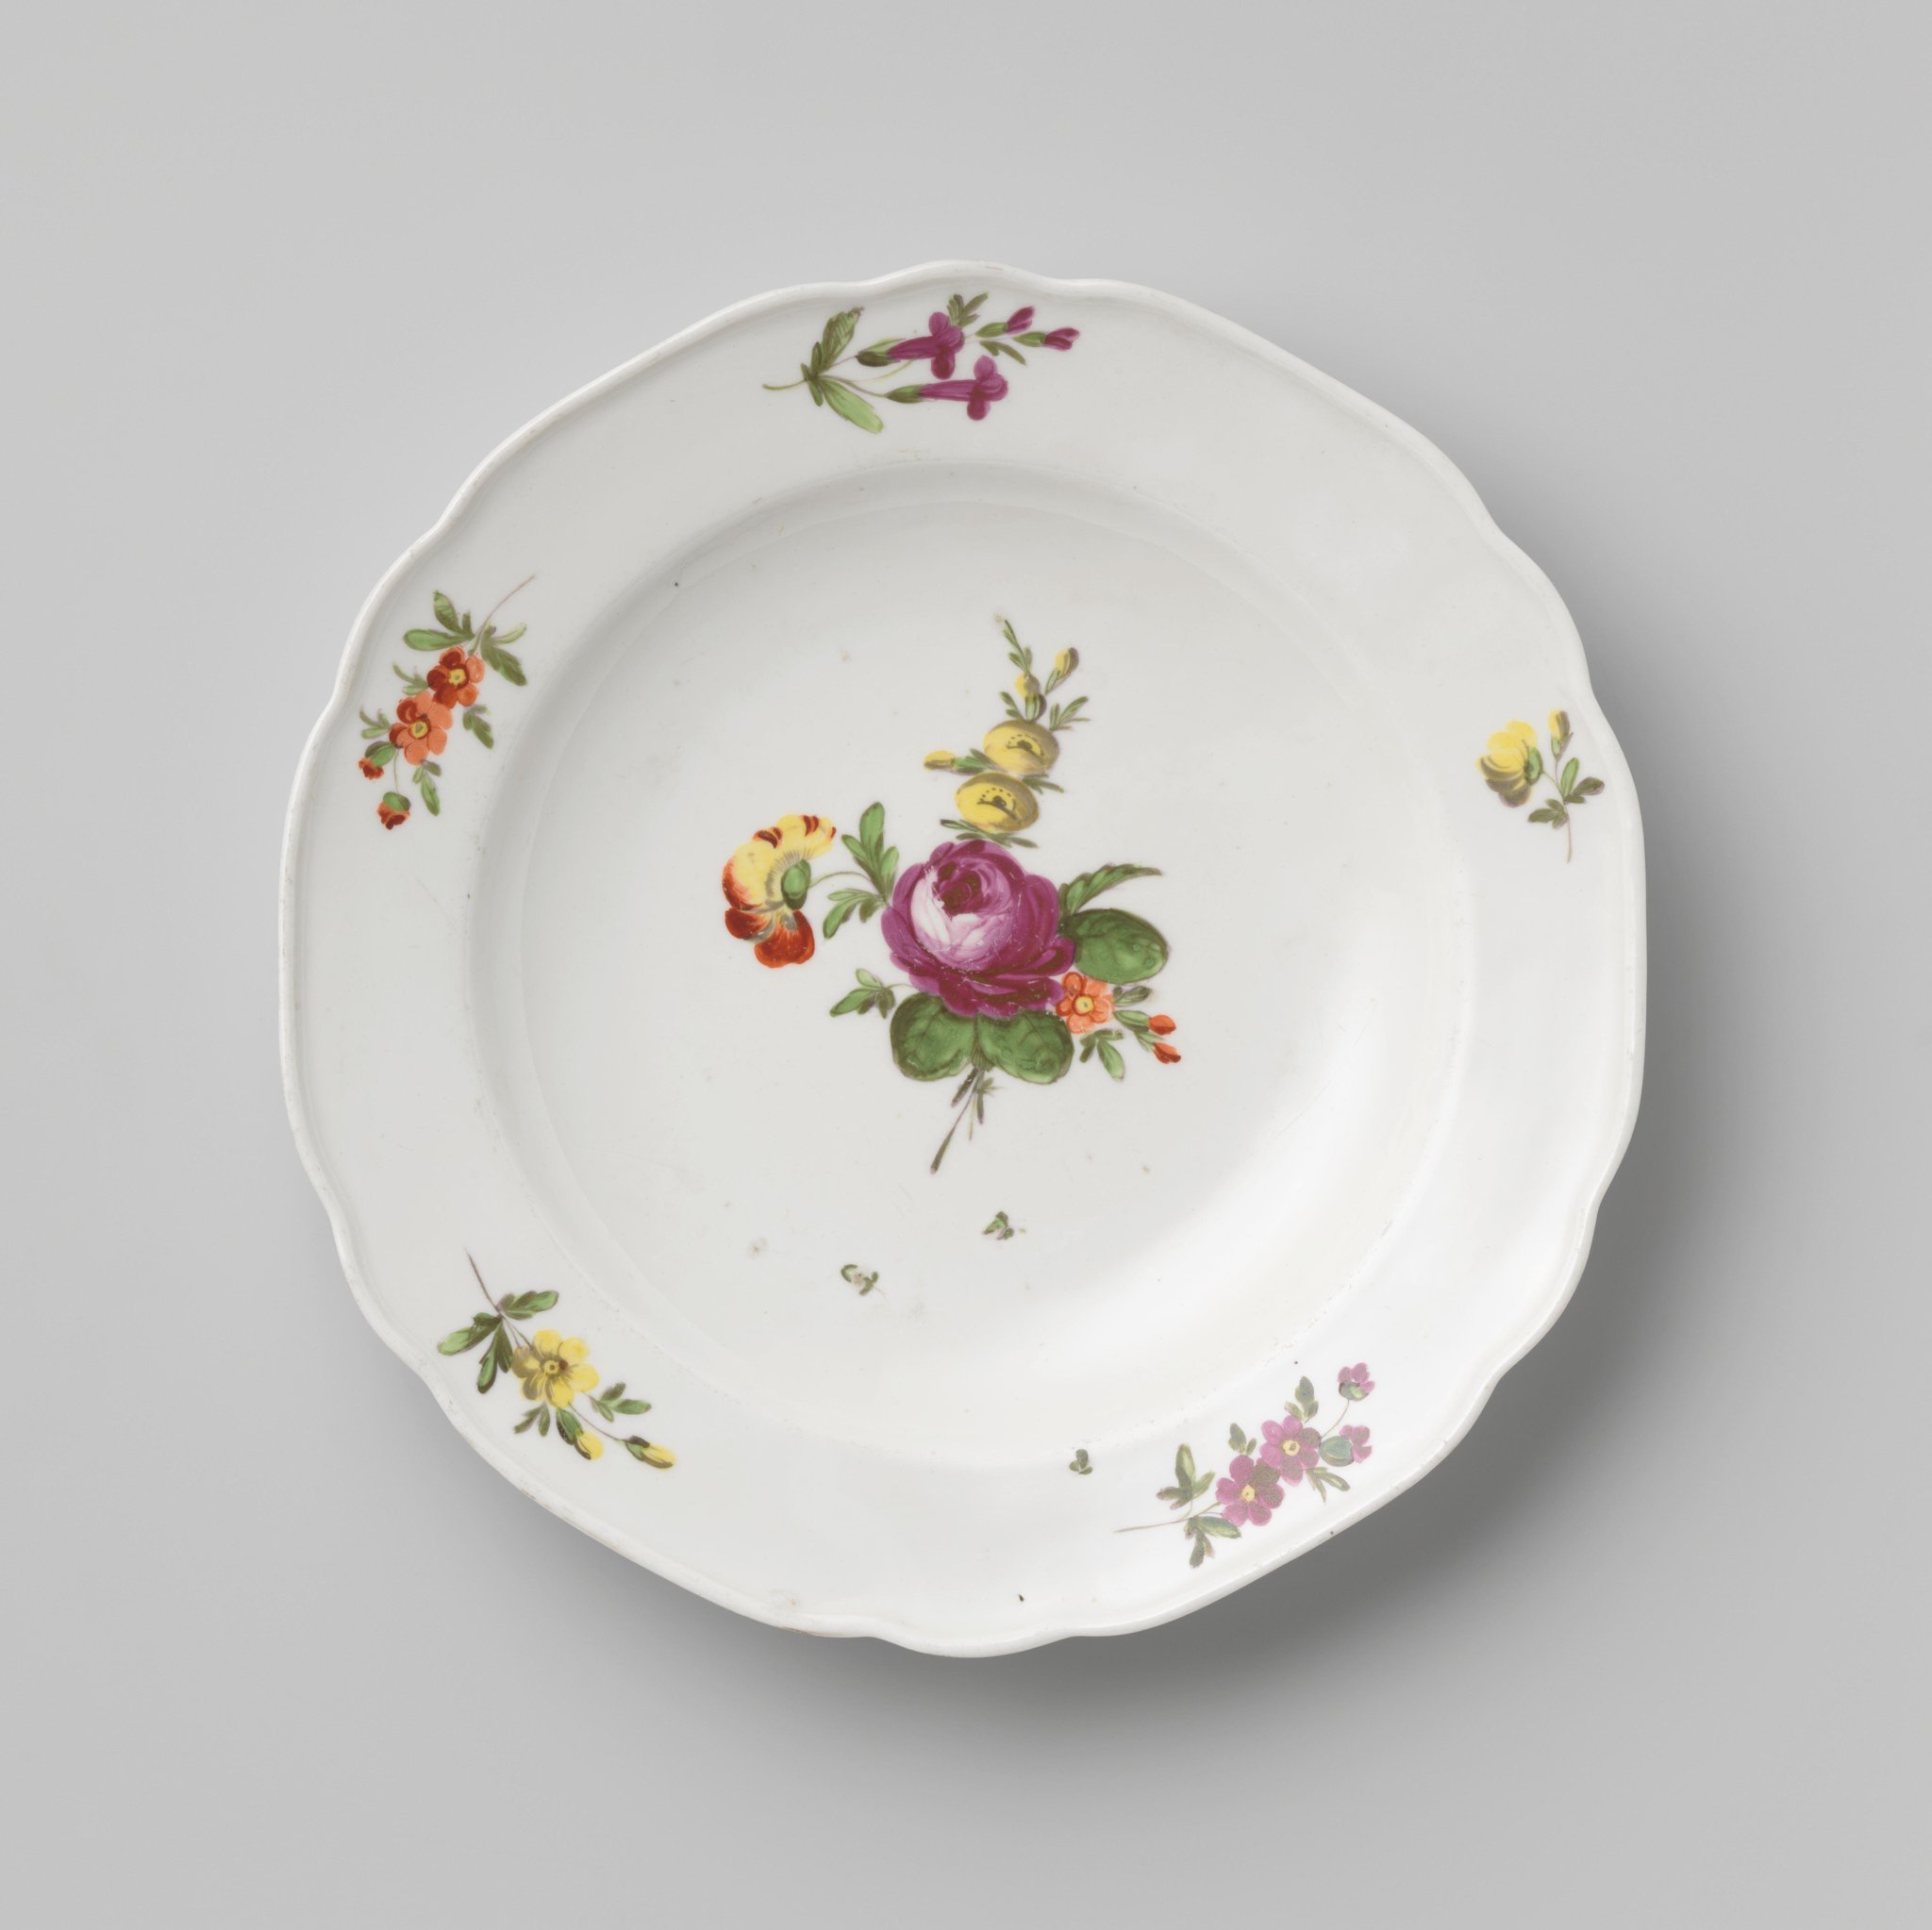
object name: service set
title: Plate with a bouquet and flower sprays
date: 1800-1849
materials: glaze, paint, porcelain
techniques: firing, forming, turning, vitrification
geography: vienna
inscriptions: mark: ‘schild/ A/ 30/ 33’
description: Bord van porselein met een gelobde rand, beschilderd op het glazuur in rood, groen, geel en paars. Op het plat een boeket van verschillende bloemen (o.a. pioenroos) omgeven door losse takjes en op de rand vijf bloemtakken. Gemerkt op de onderzijde met het schild, de letter A en de nummers 30 en 33.